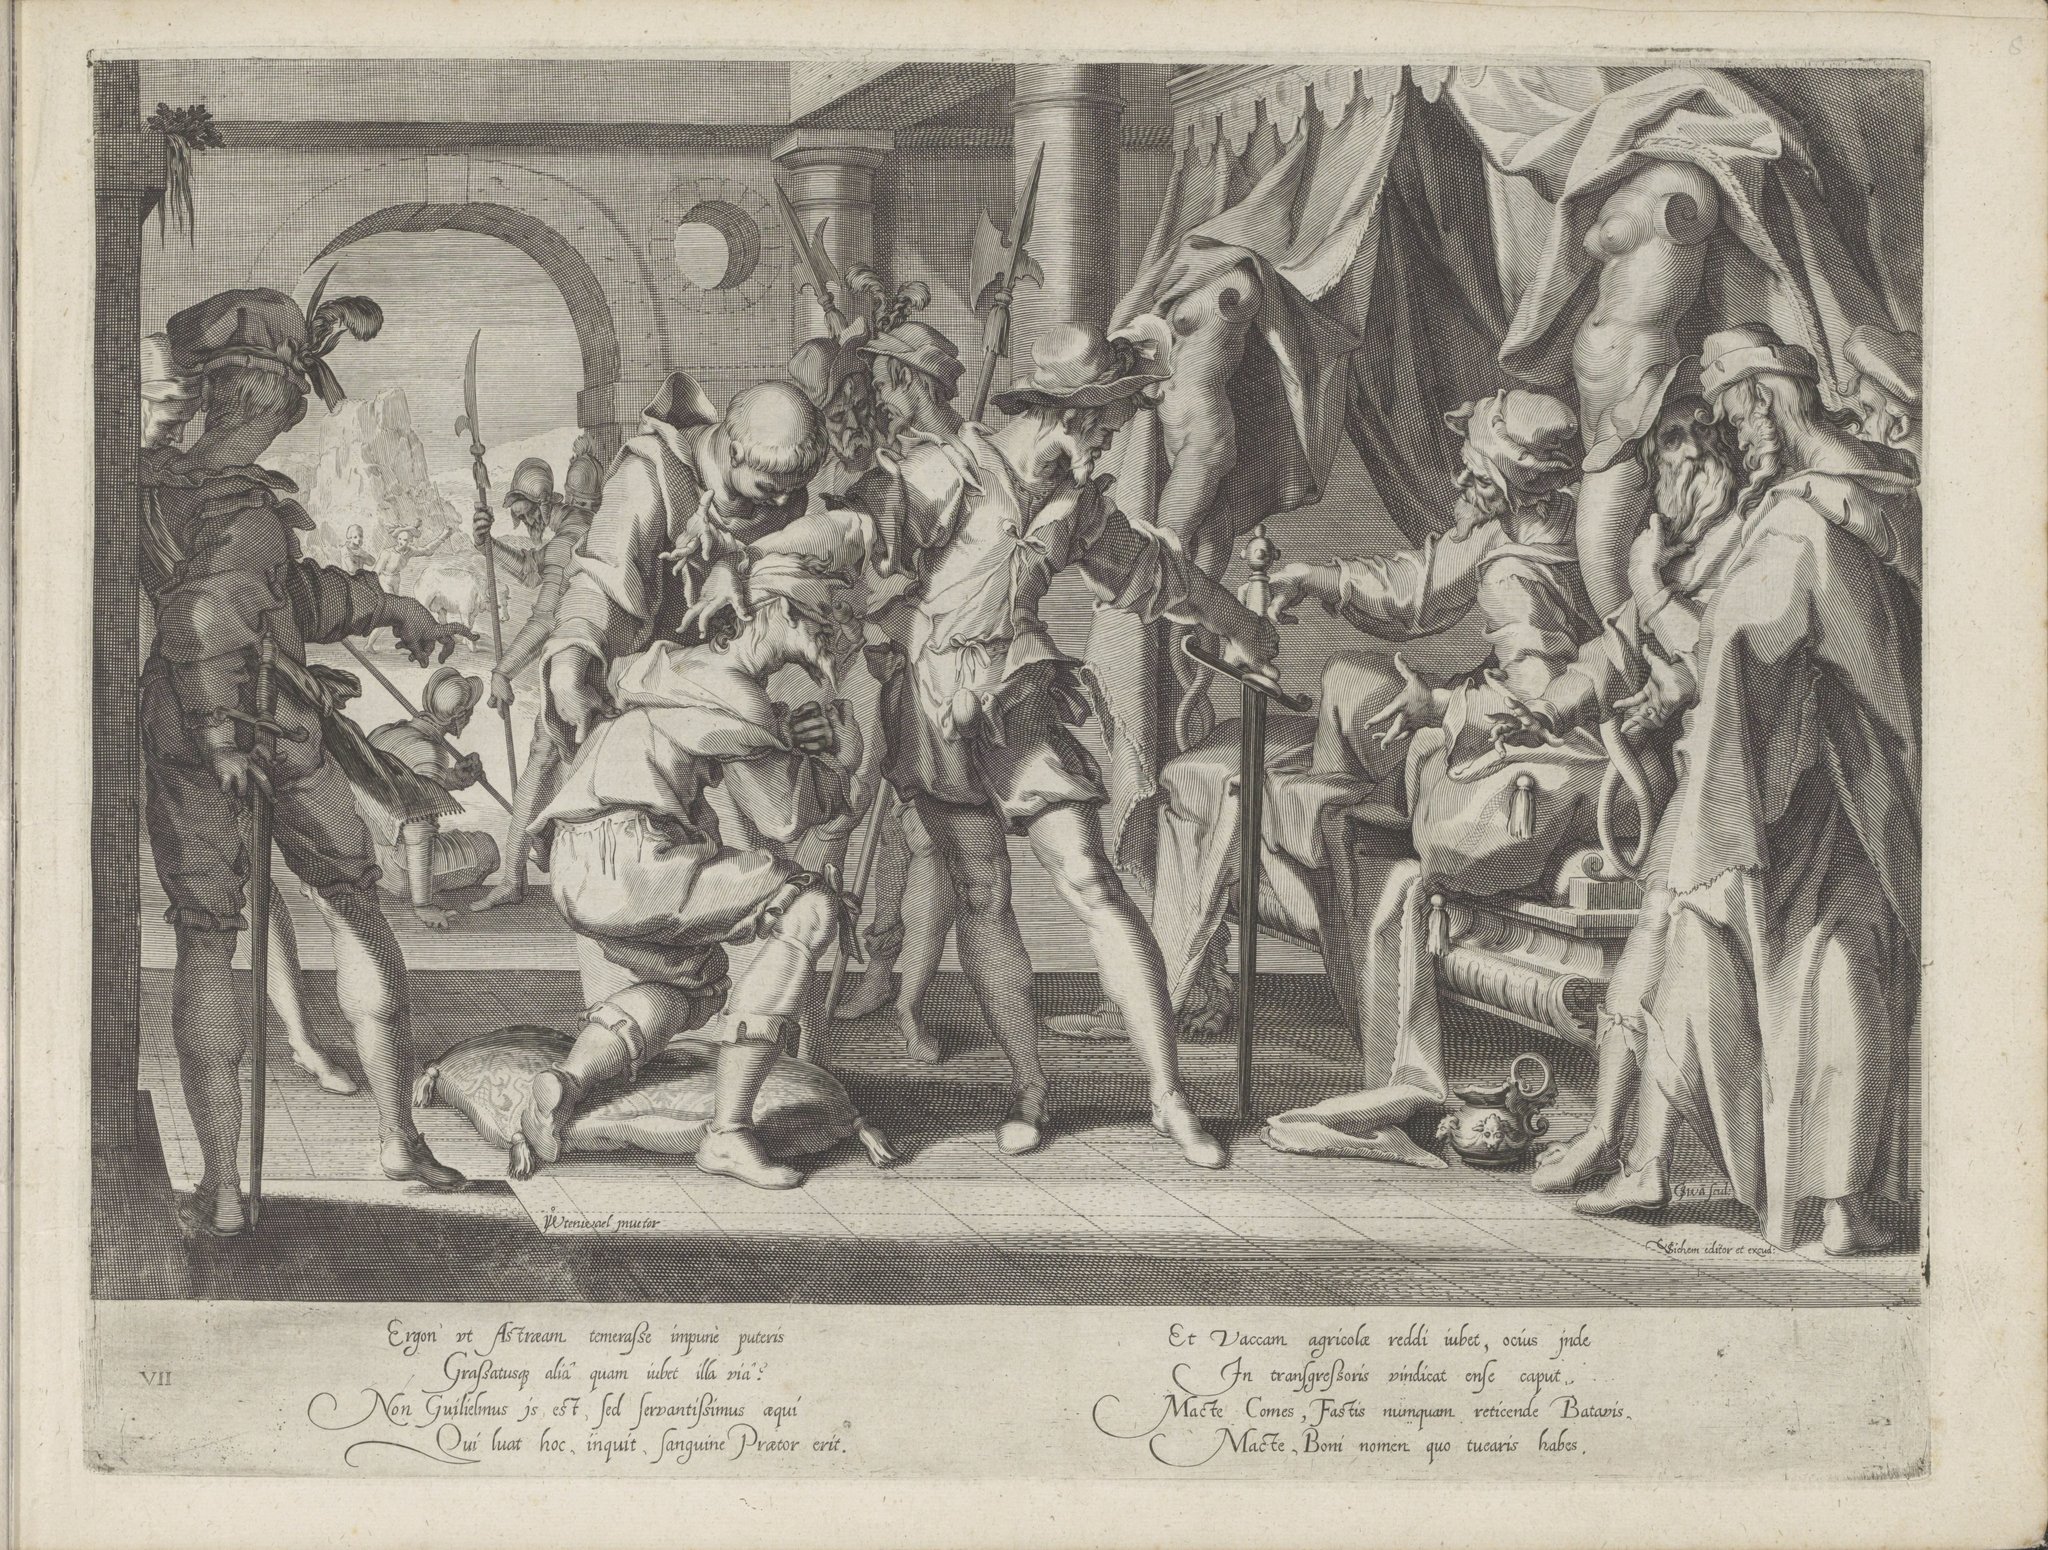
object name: album leaf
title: Thronus Justitiae duodecim pulcherrimis tabulis artificiosissime aeri incisis illustratus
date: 1606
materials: paper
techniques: engraving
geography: amsterdam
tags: willem iii de goede (graaf van holland en henegouwen), sick-bed, violent death by beheading, juridical examples; exemplary judges; 'gerechtigkeitsbilder'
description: Willem III de Goede, graaf van Holland en Henegouwen, veroordeelt vanaf zijn ziekbed zijn baljuw en geeft opdracht hem te onthoofden. Op de achtergrond is de aanleiding te zien: de baljuw heeft een boer opgelicht door hem een slechte koe te verkopen voor een goede. Onder de voorstelling twee vierregelige verzen in het Latijn. De prent maakt deel uit van een album.